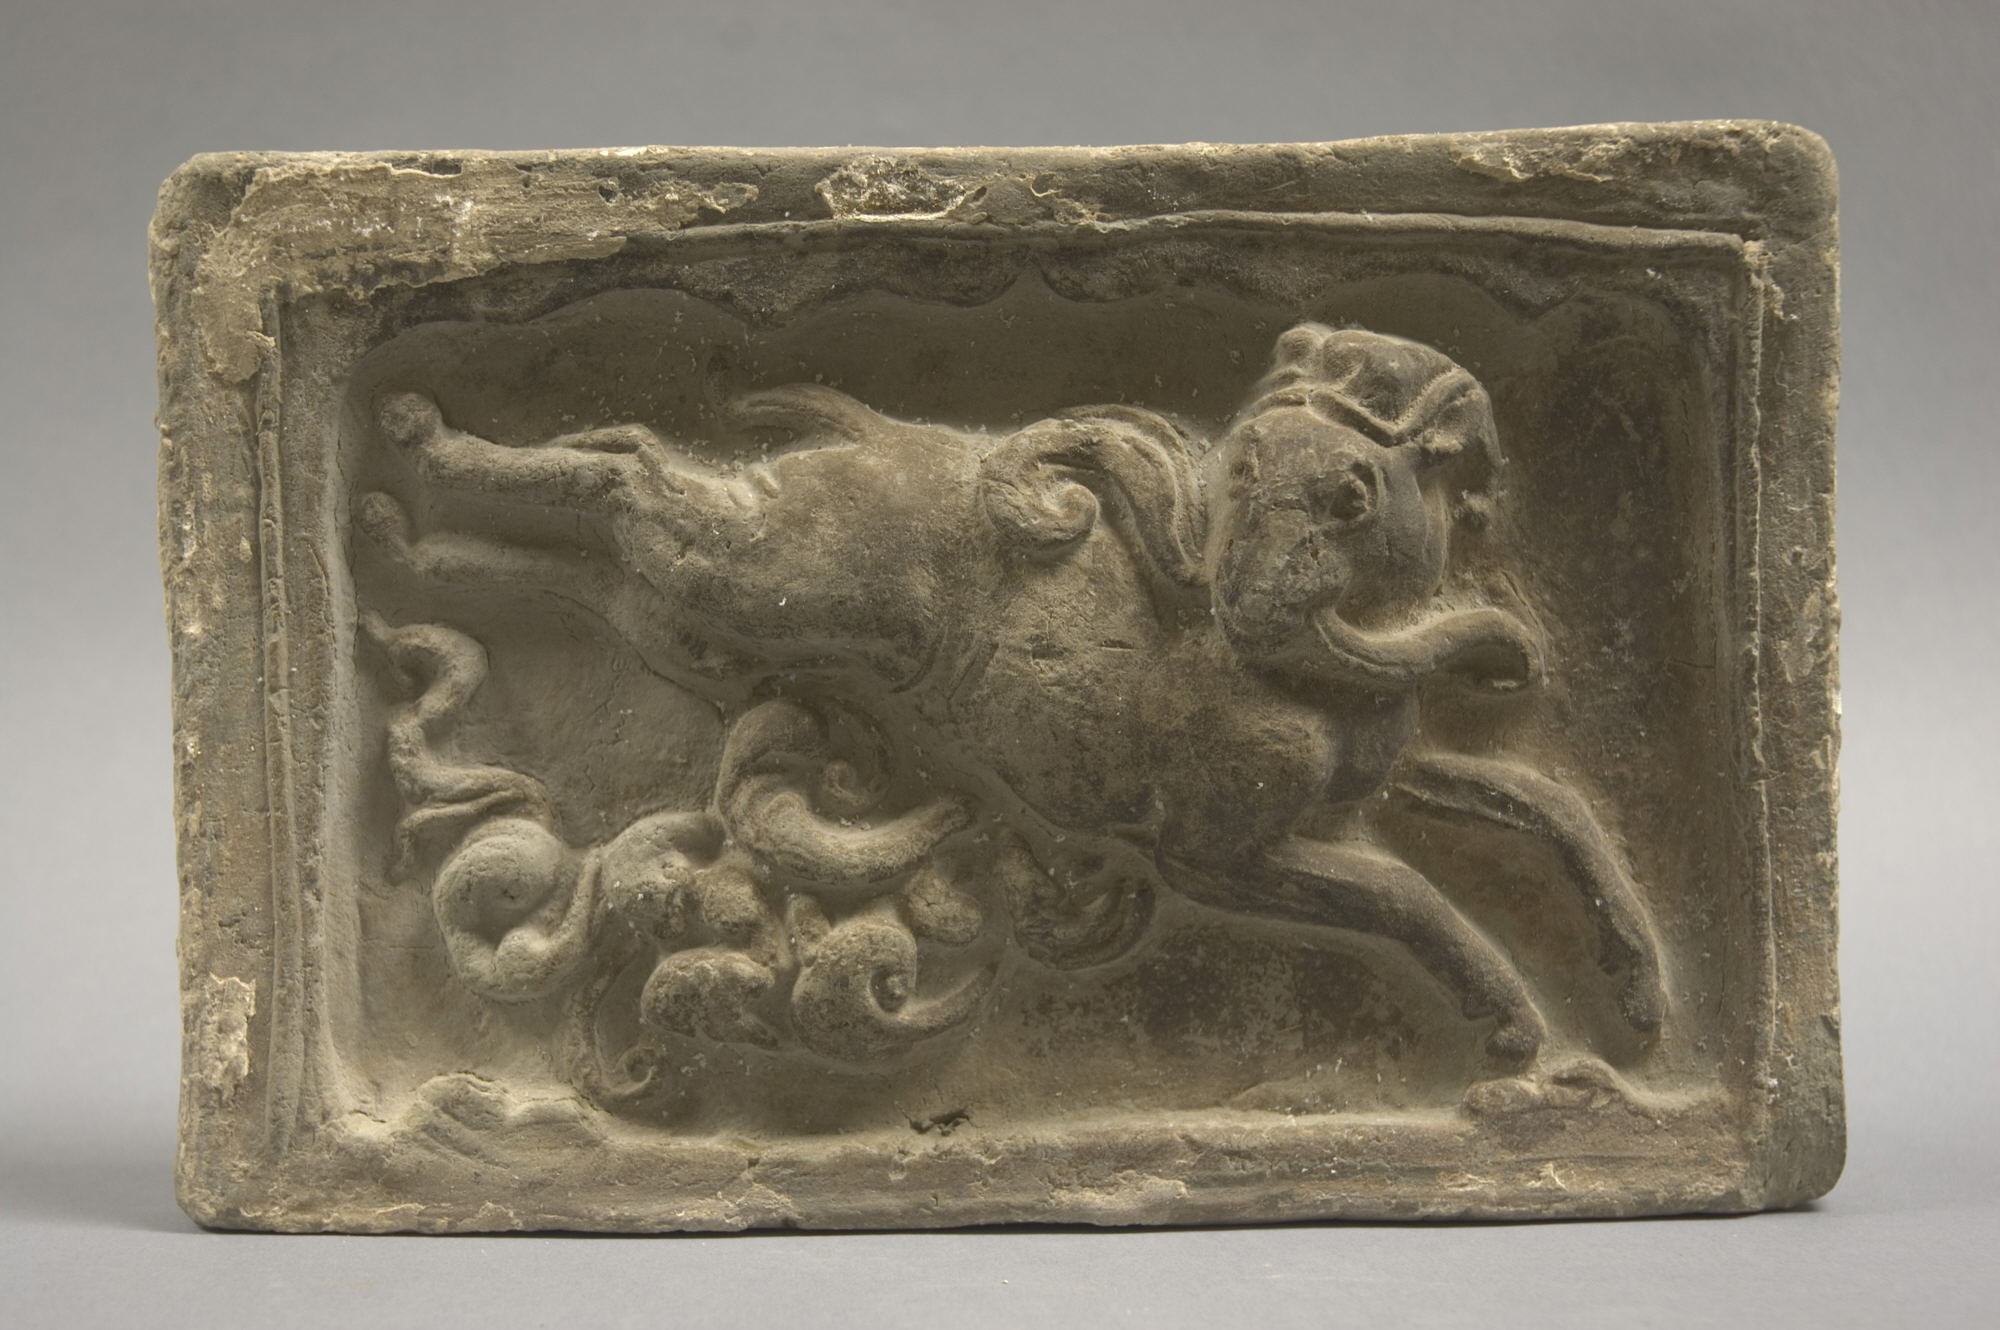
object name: tile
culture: chinese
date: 960-1644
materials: terracotta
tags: animals